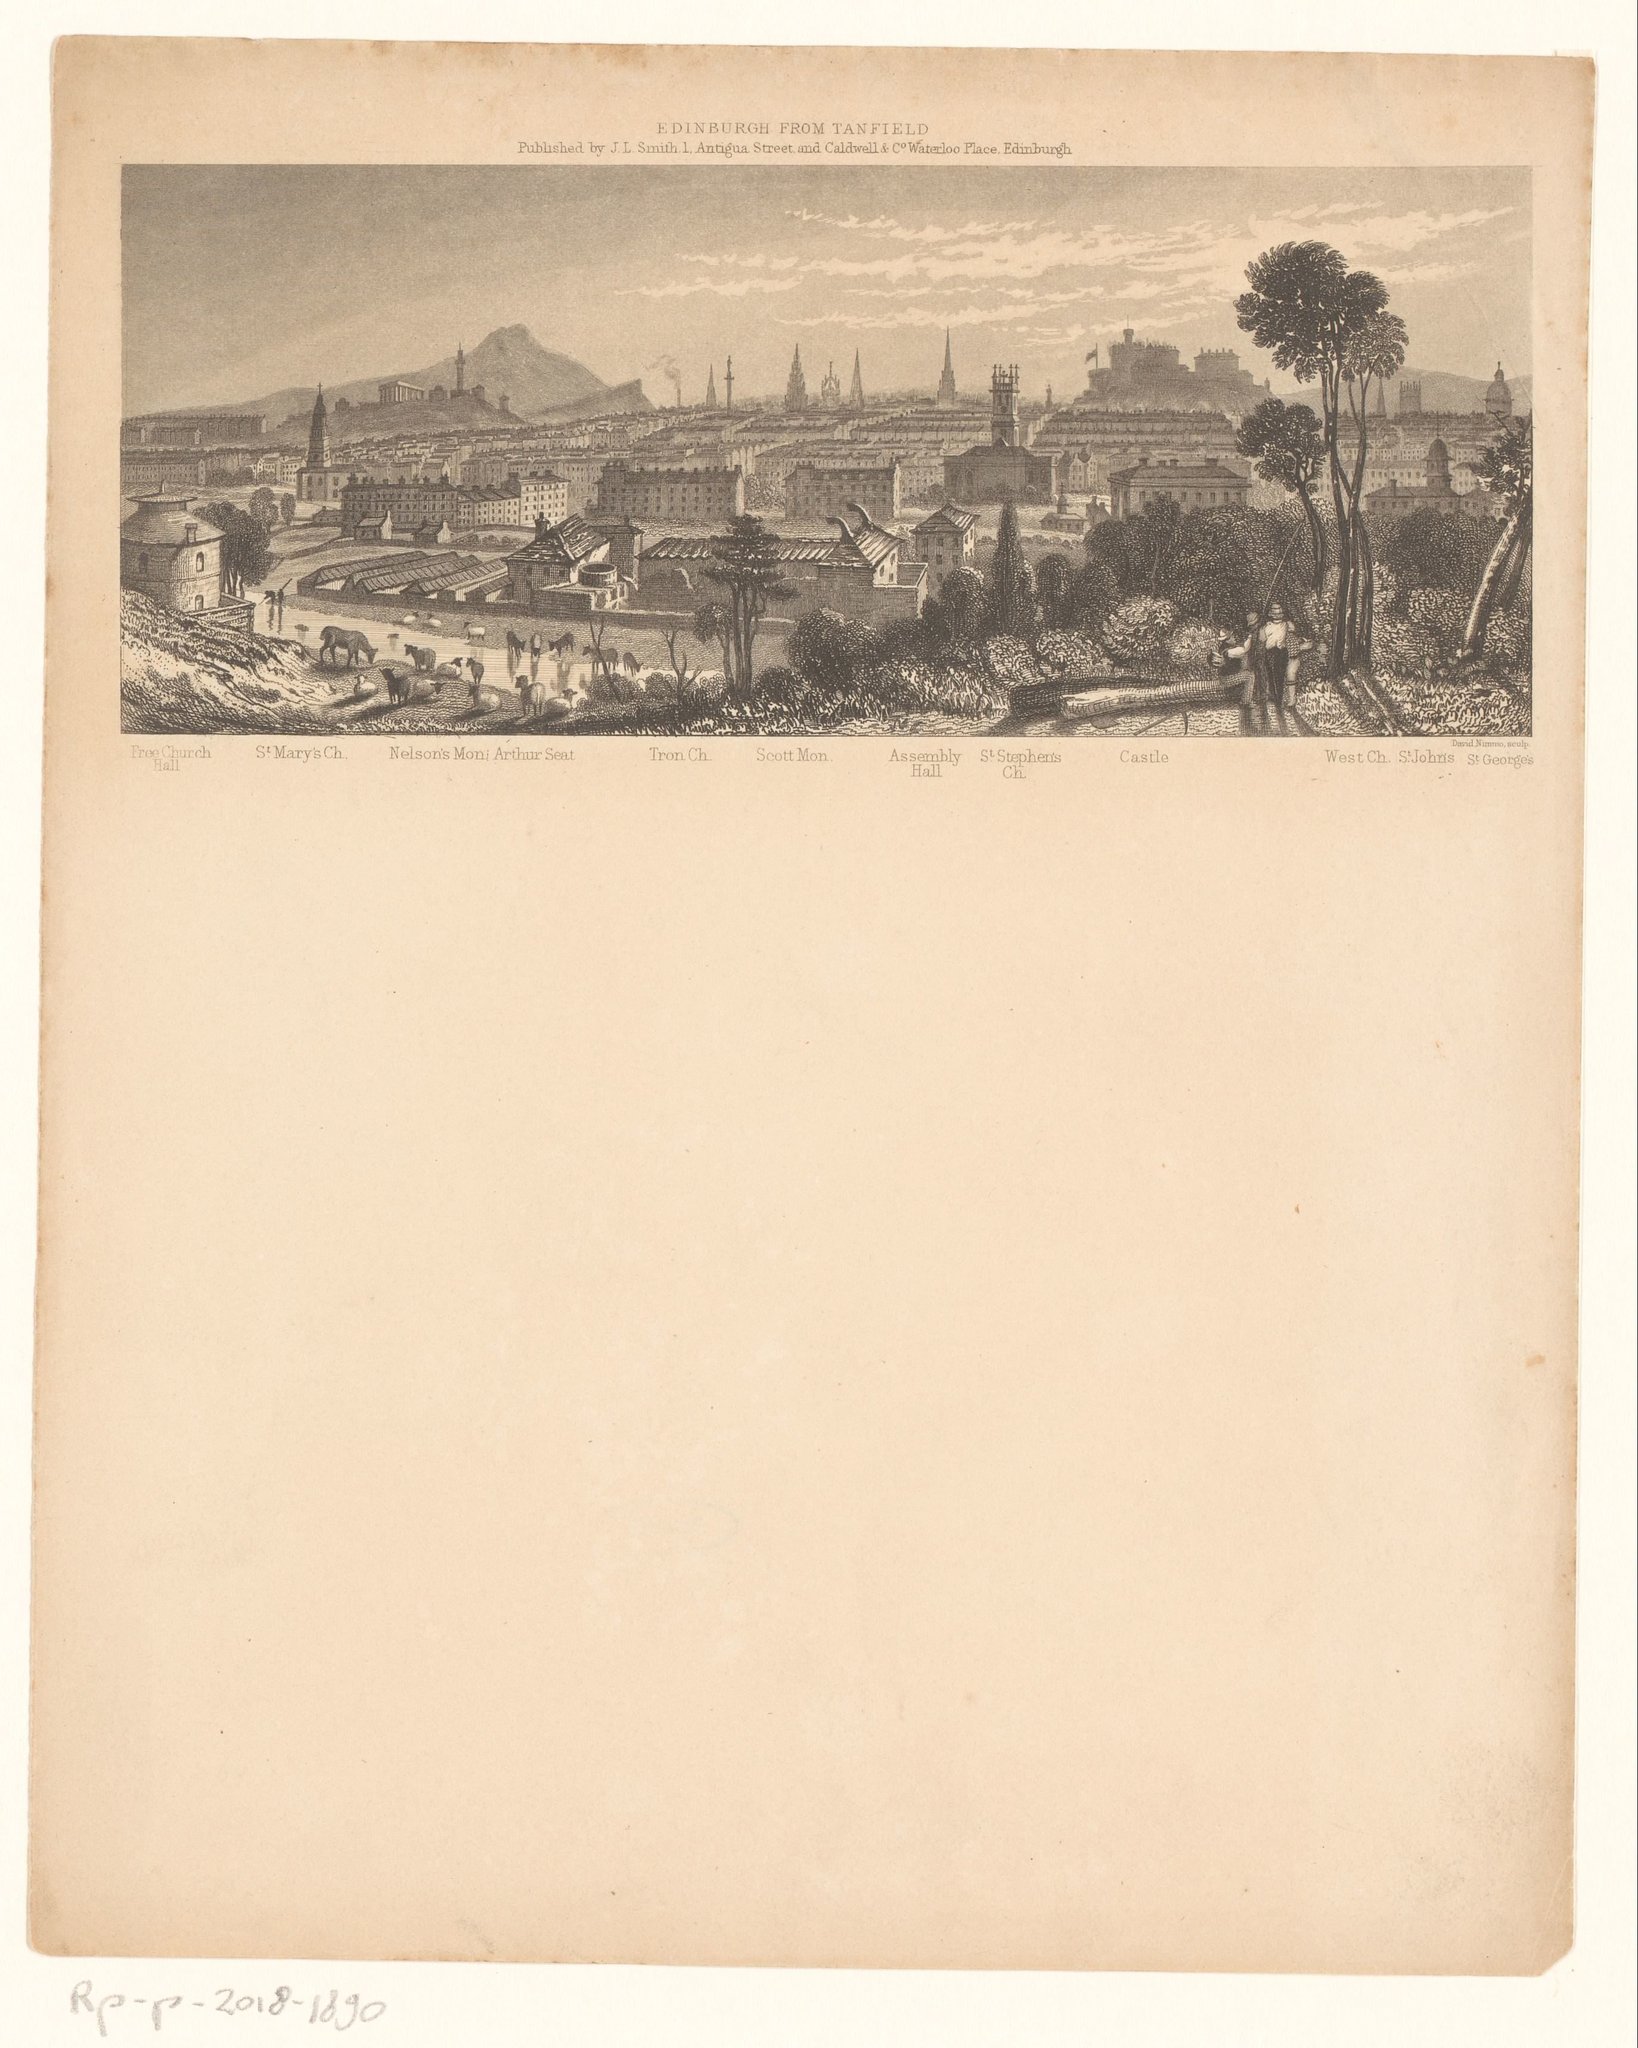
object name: print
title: Gezicht op Edinburgh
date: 1845-1899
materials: paper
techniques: engraving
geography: edinburgh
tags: prospect of city, town panorama, silhouette of city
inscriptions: collector's mark: Lugt 2228